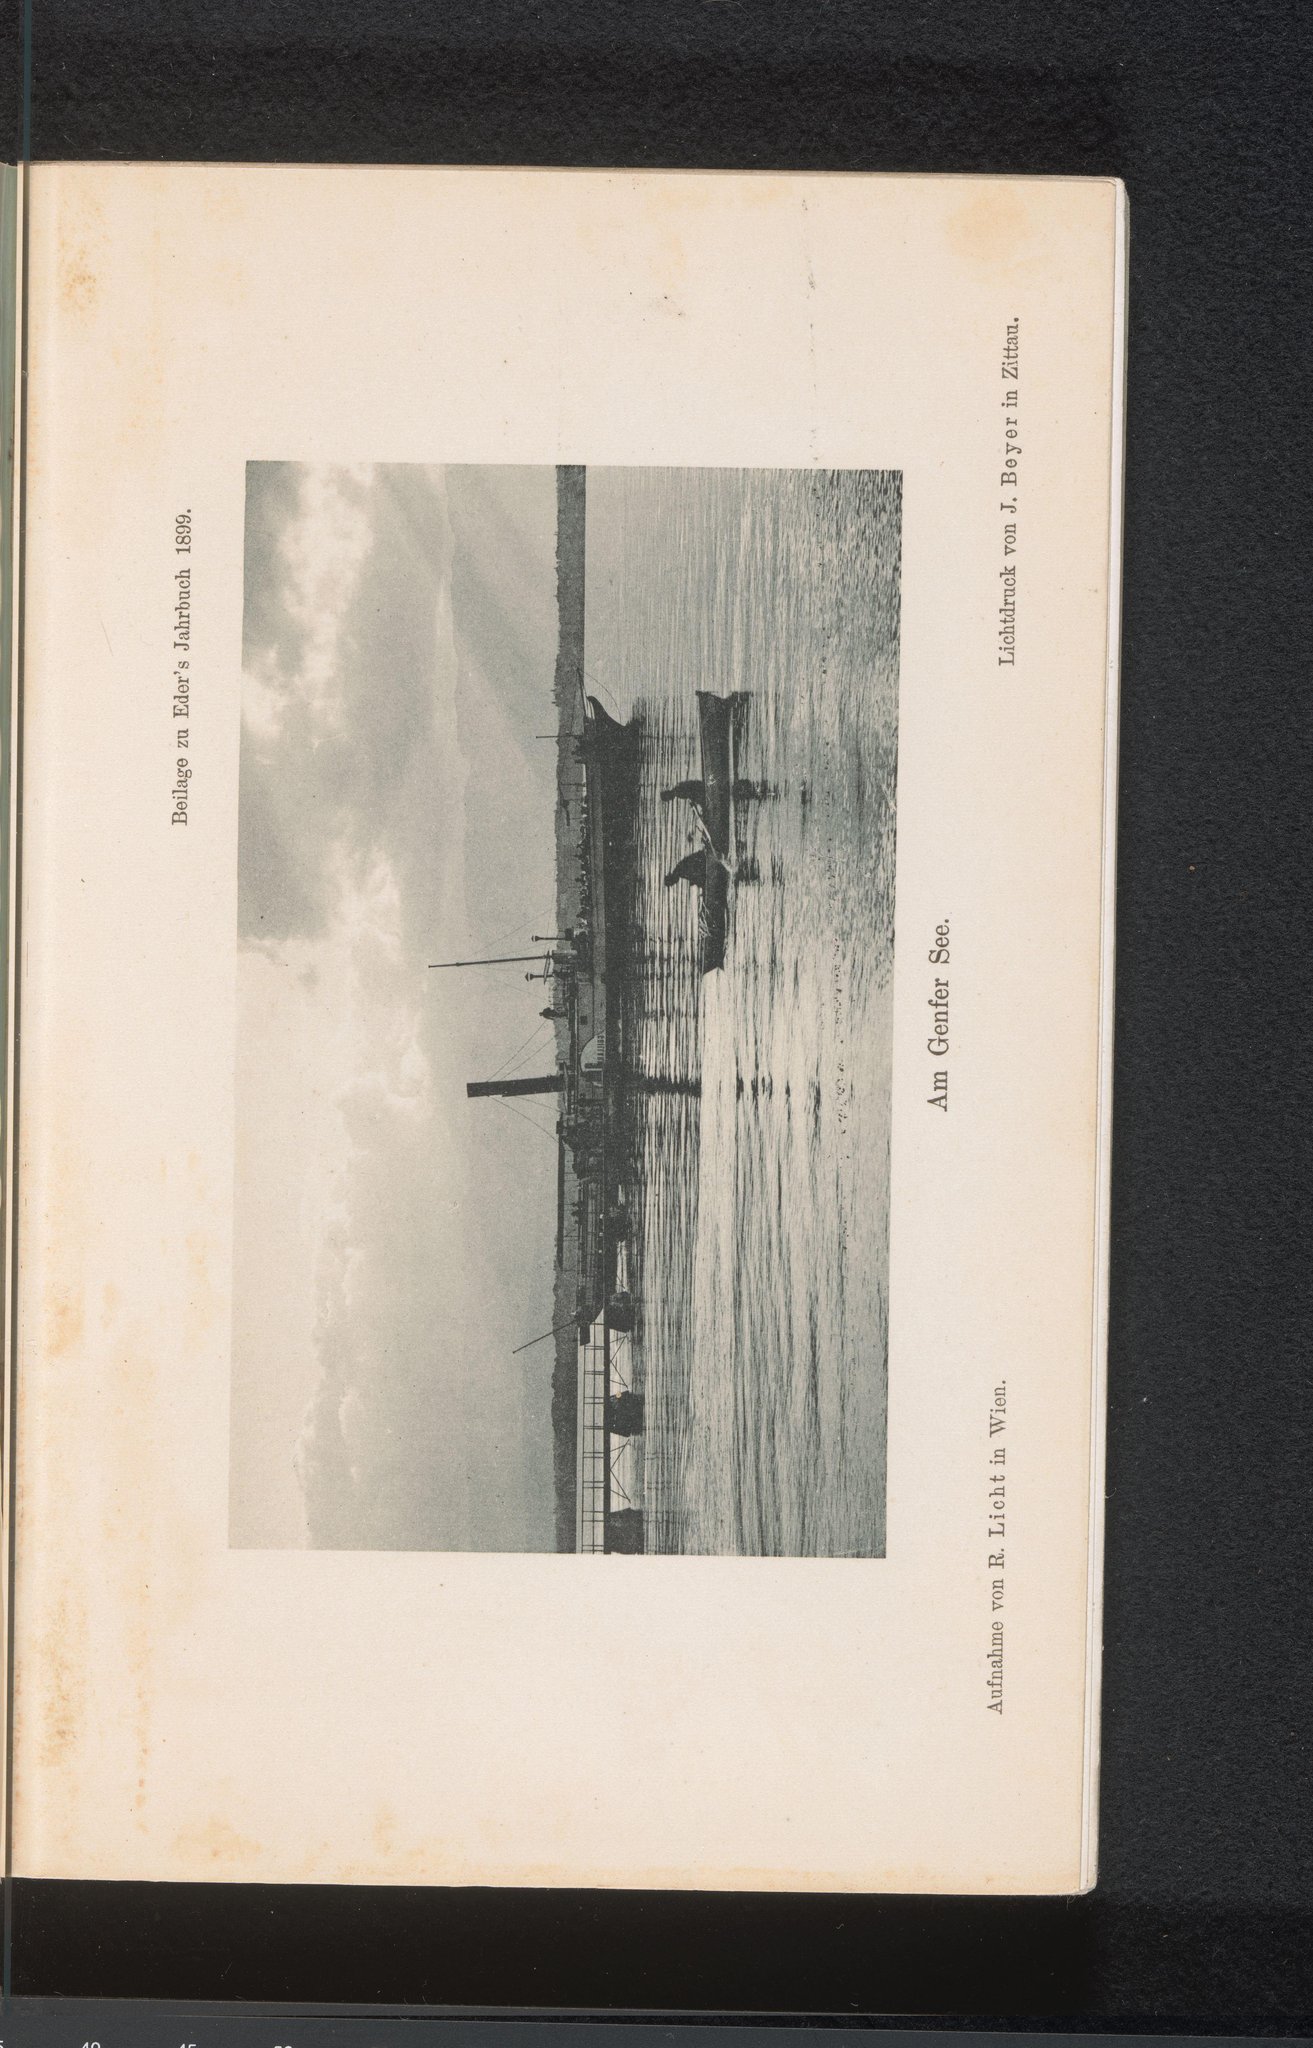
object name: page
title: Am Genfer See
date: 1894-1899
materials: paper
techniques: photograph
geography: lake geneva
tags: ships (in general), rowing-boat, canoe, etc., lake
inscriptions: inscription: ‘Beilage zu Eders Jahrbuch 1899’